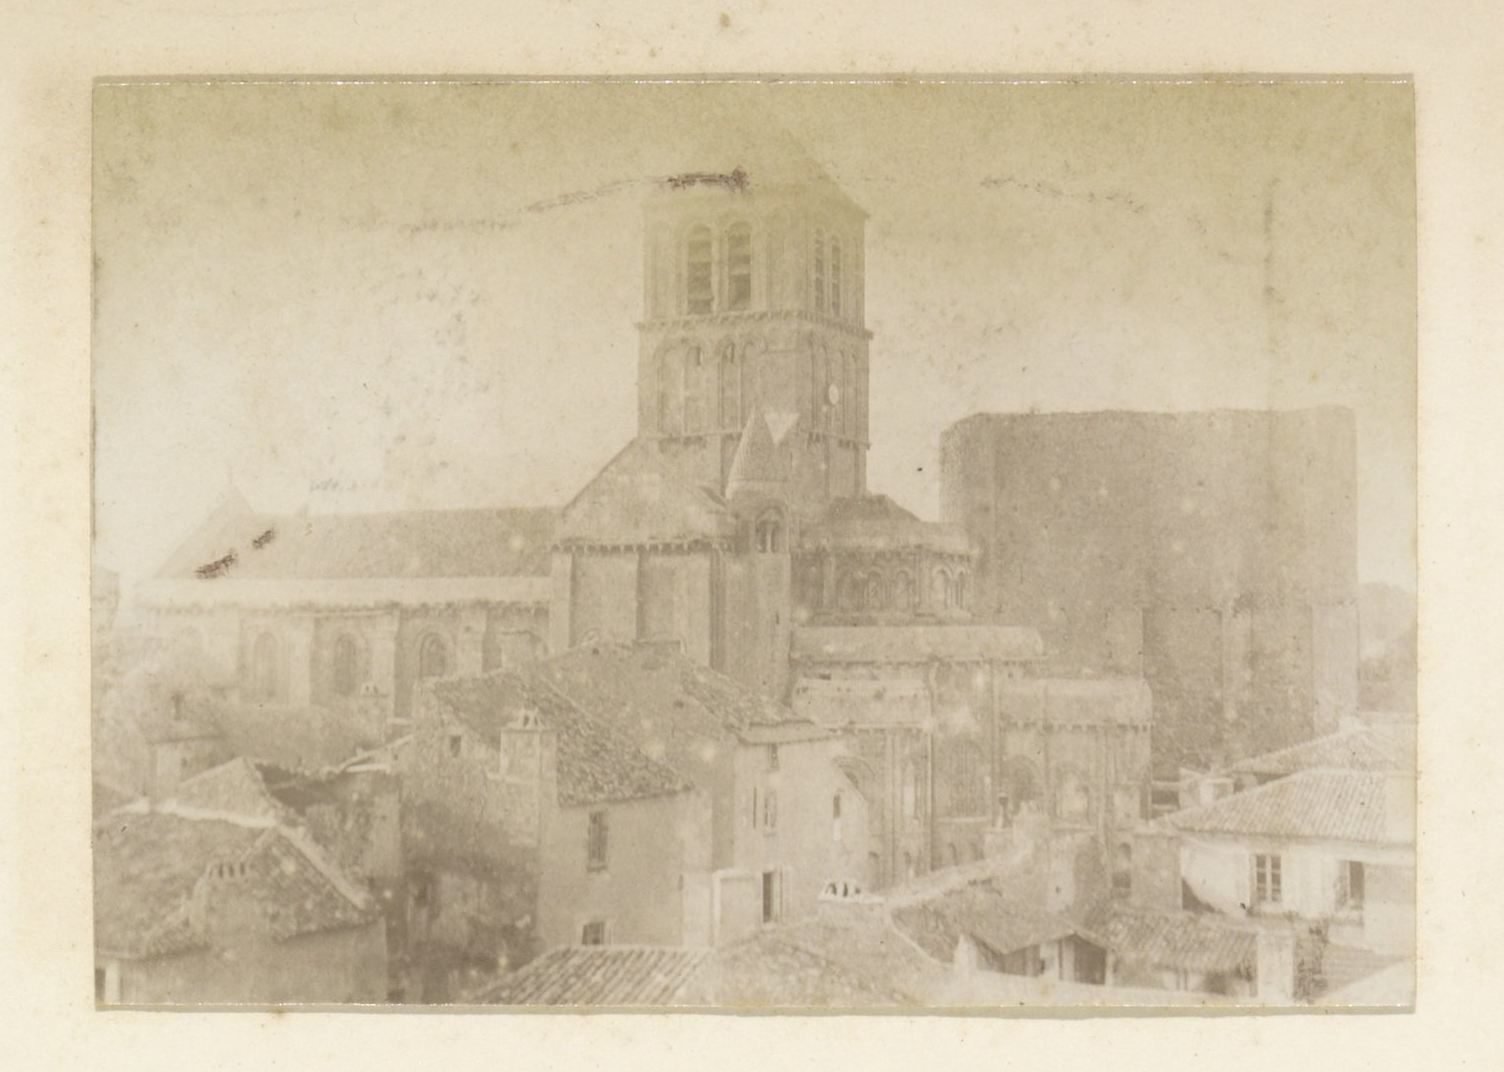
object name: photograph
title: Gezicht op een stad met een kerk in Frankrijk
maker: Anonymous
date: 1900-1910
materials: paper, photographic support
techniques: albumen print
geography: france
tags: church (exterior), prospect of city, town panorama, silhouette of city, france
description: Onderdeel van Fotoalbum van een Franse amateurfotograaf met opnames van een familie, distilleerderij Delizy & Doistau Fils, het leger en bezienswaardigheden in Frankrijk.